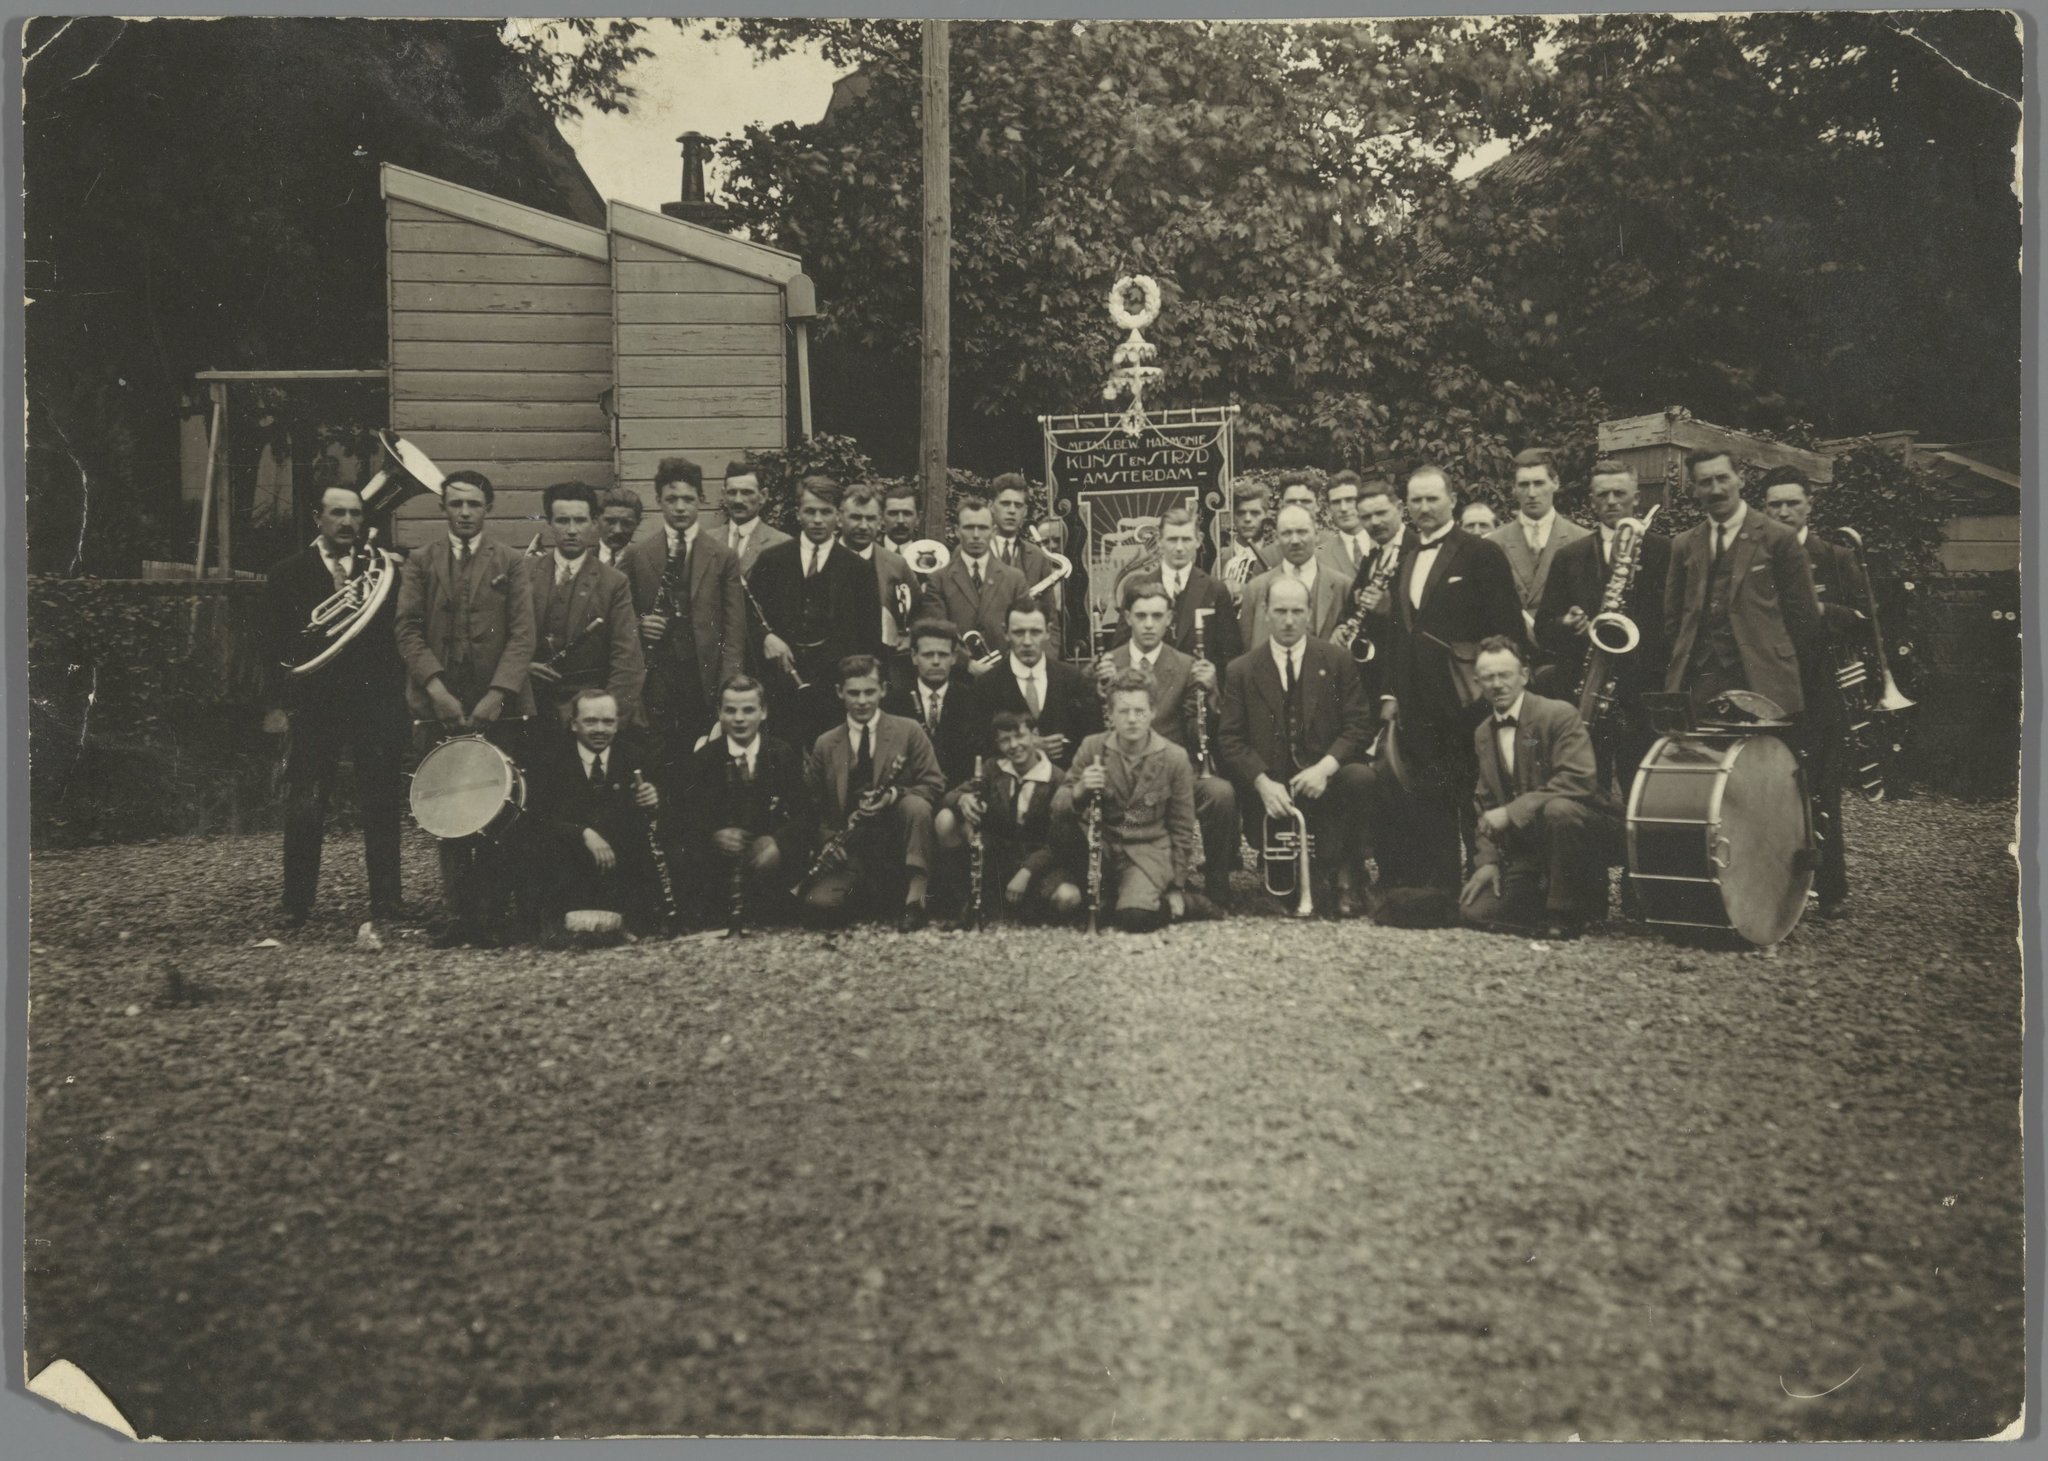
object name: photograph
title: Concours Krommenie 'Kunst en strijd' in Amsterdam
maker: Anonymous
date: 1926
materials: photographic support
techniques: gelatin silver print